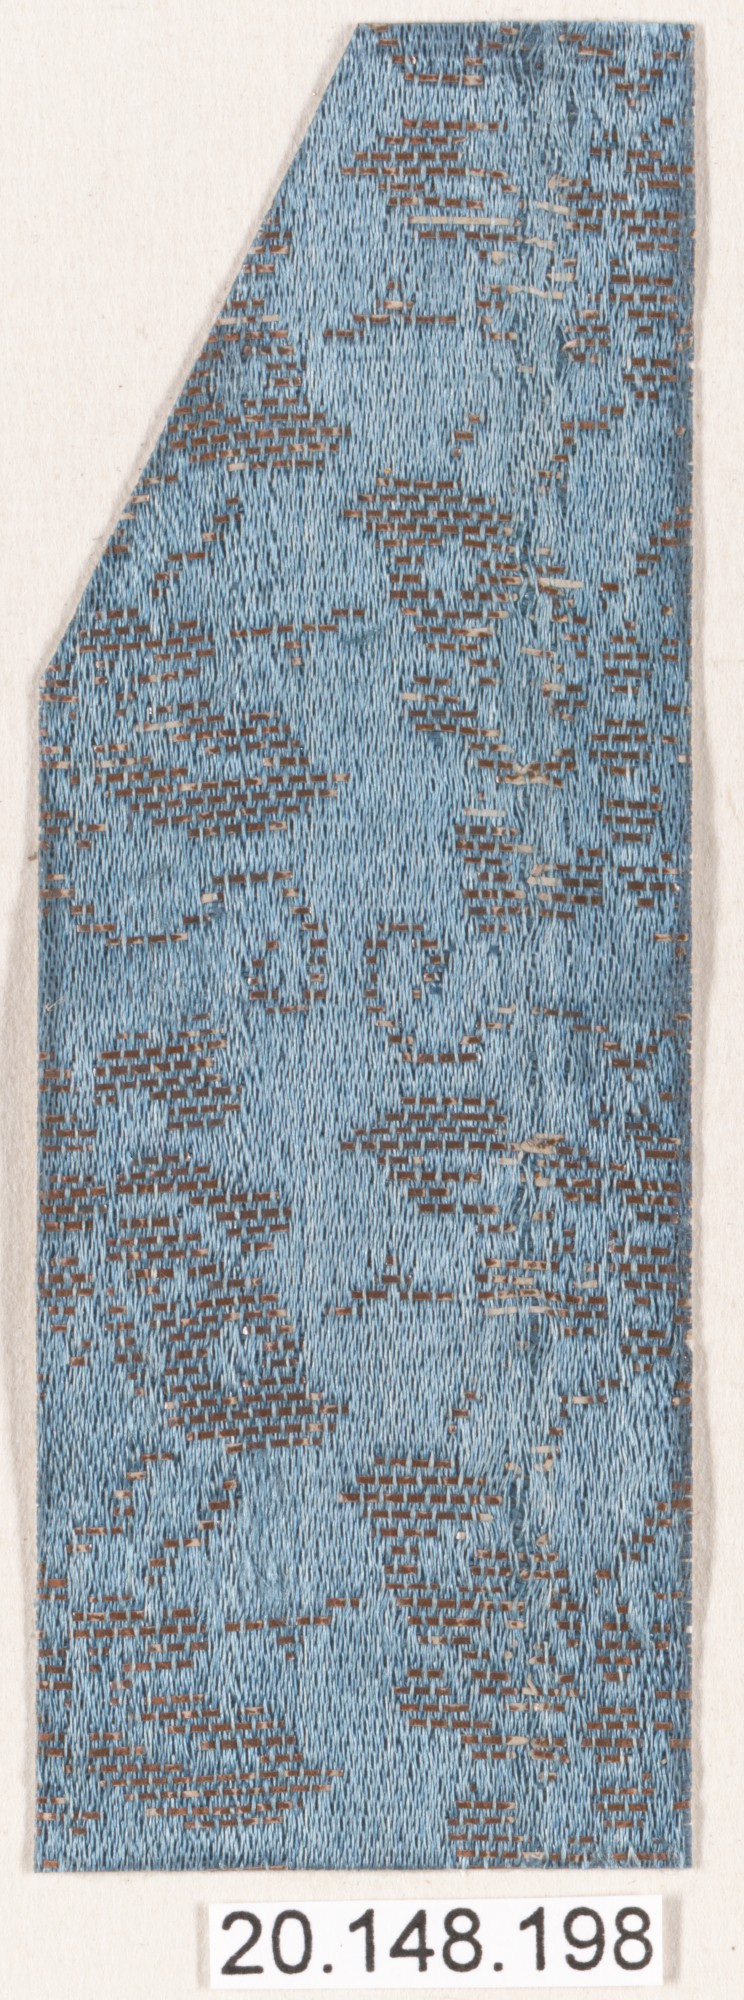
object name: piece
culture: japanese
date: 1701-1800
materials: silk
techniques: compound weave